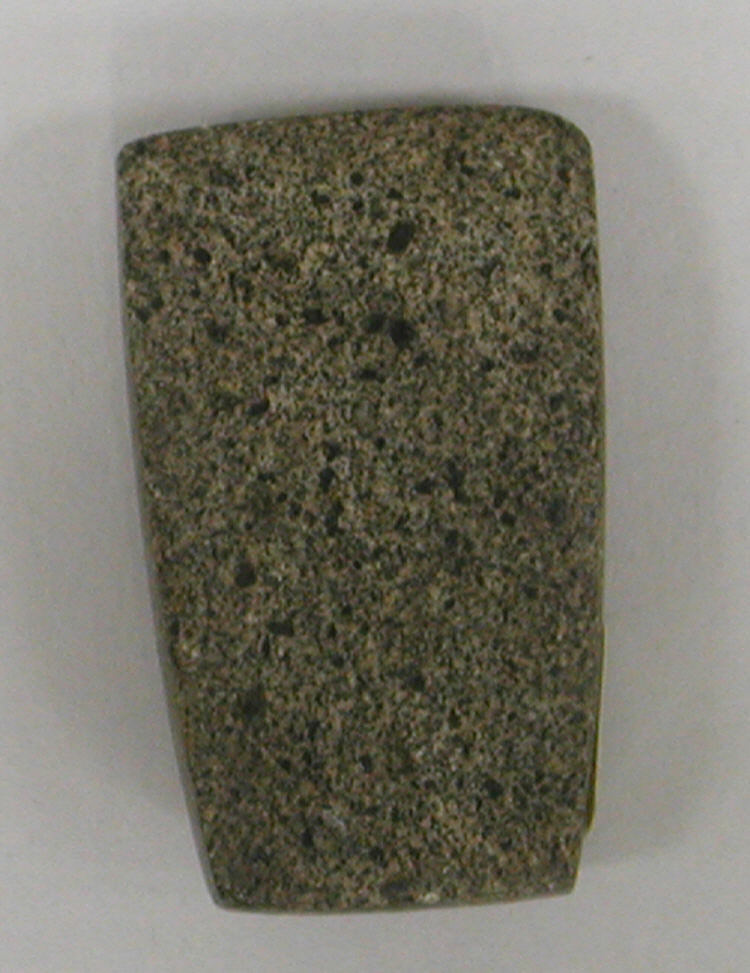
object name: chisel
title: Stone Chisel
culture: mexican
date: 1501-1600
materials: stone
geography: mexico